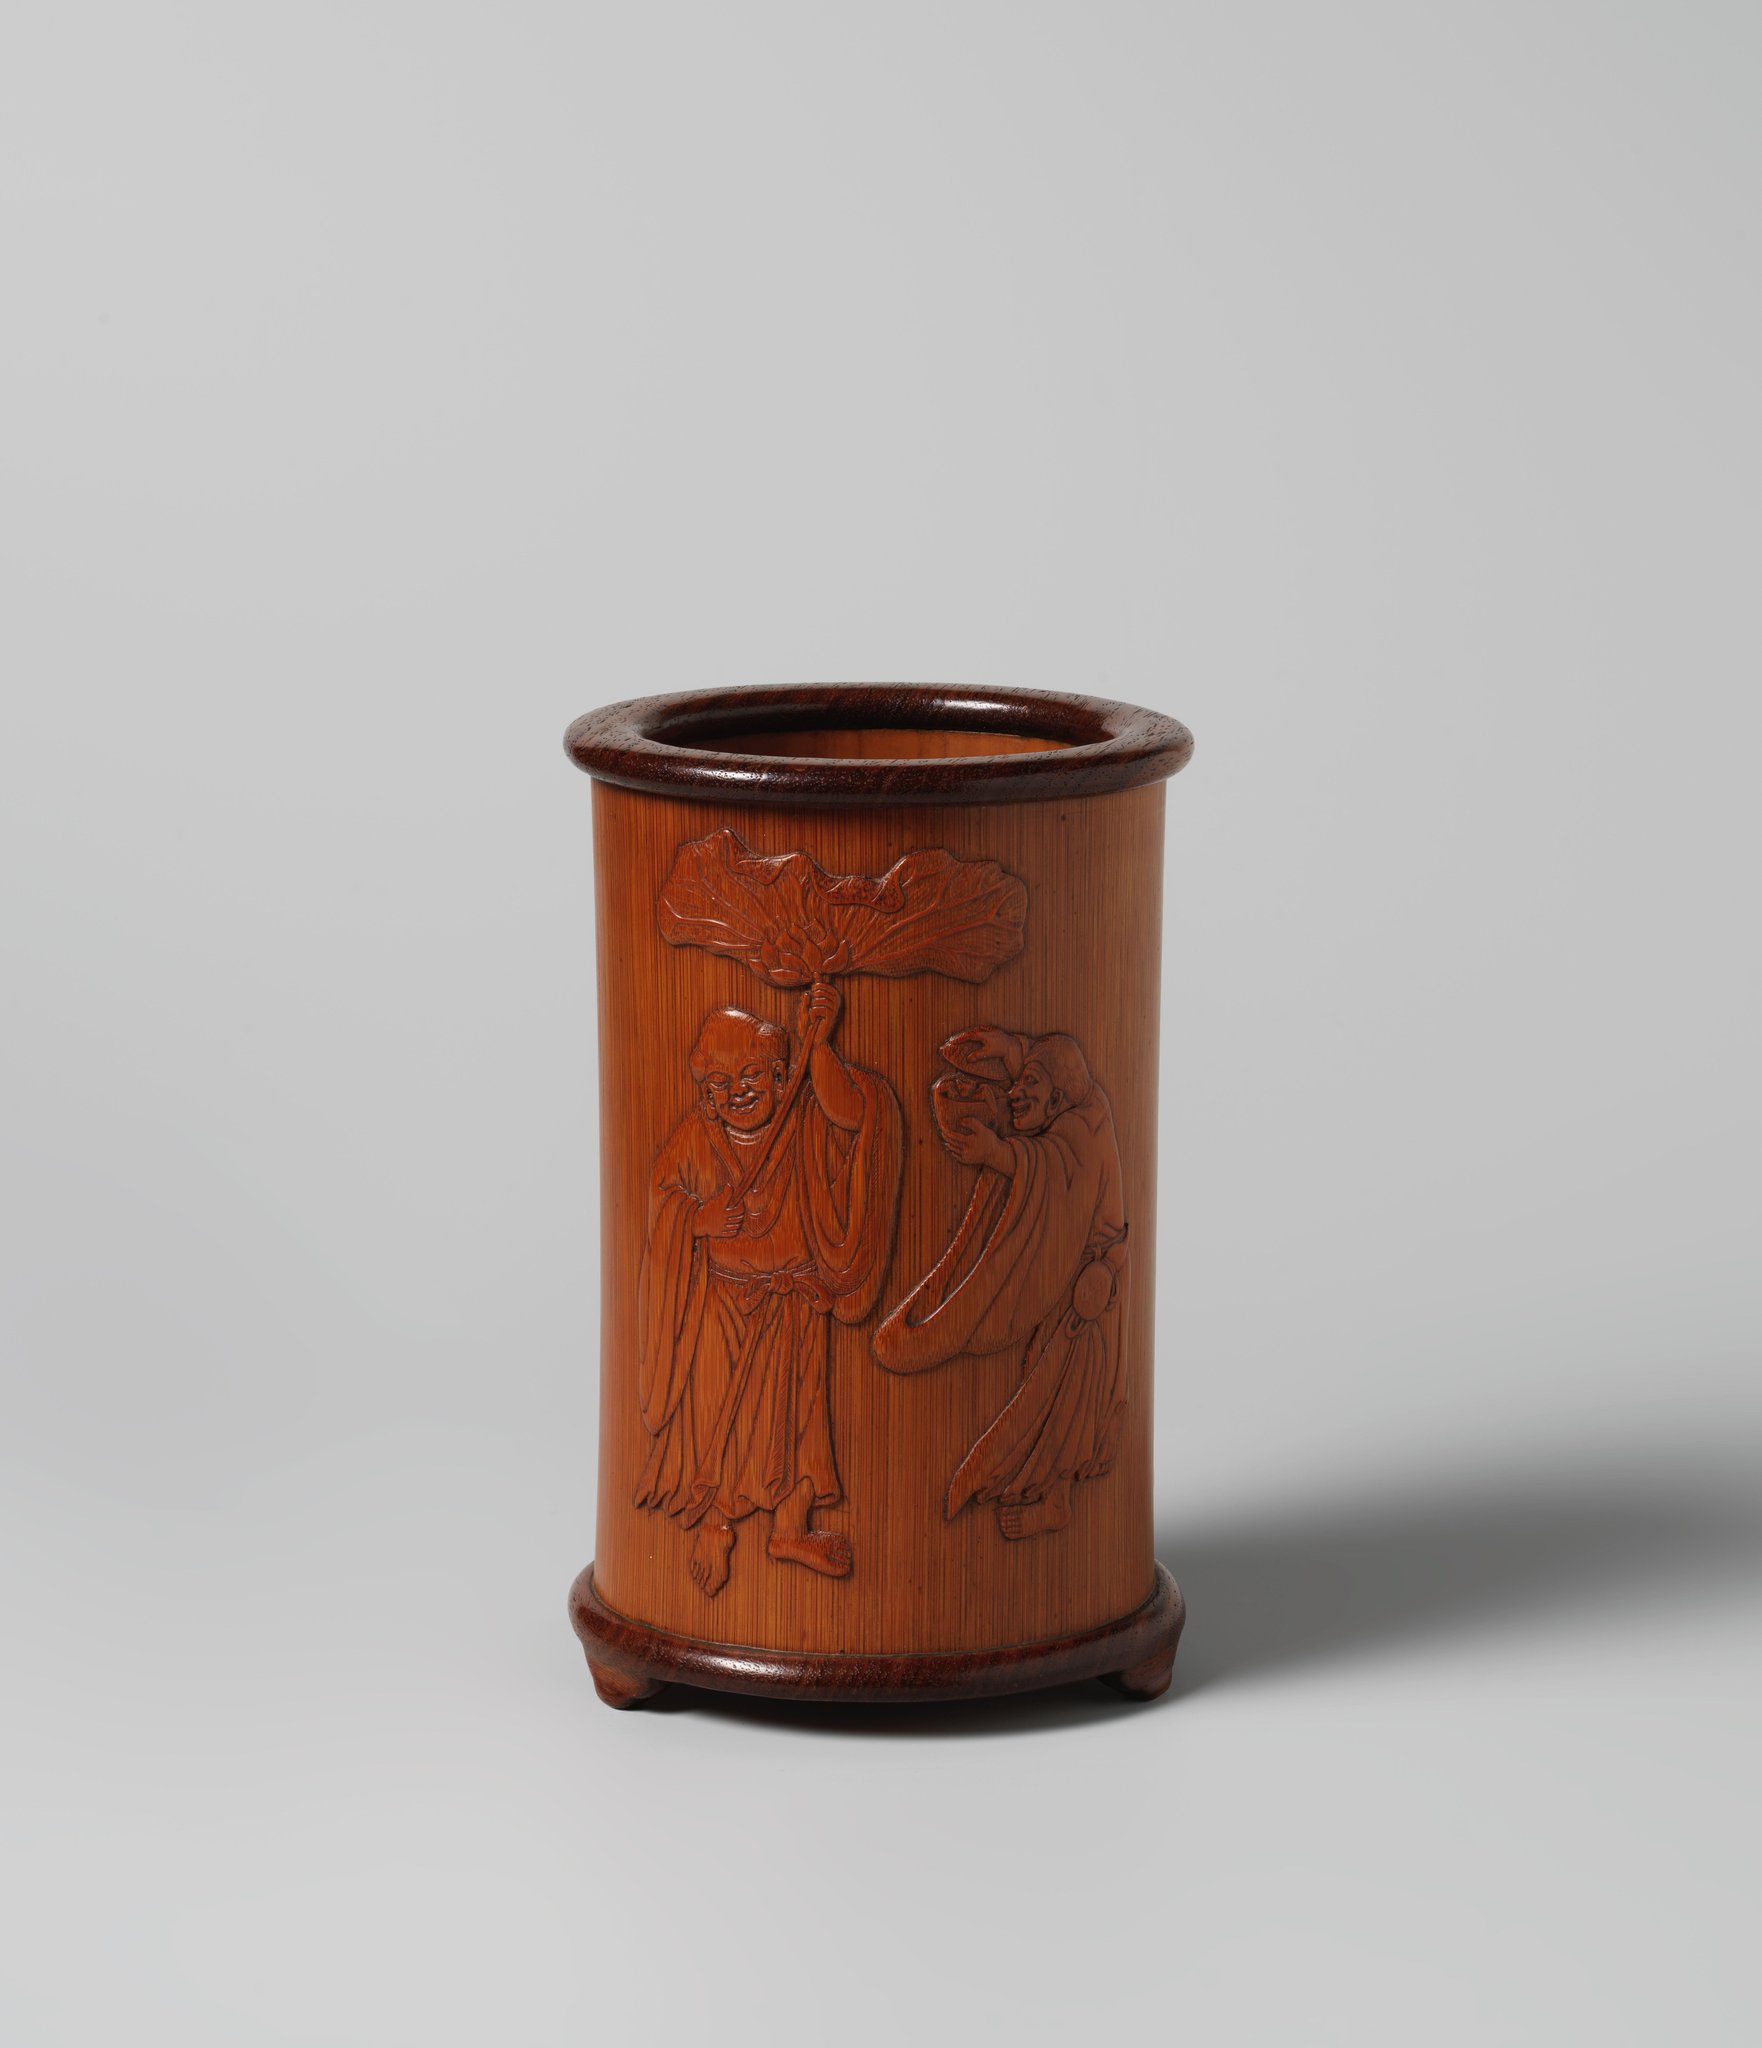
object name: brush holder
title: Brush holder decorated with Hanshan and Shide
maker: danian ma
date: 1644-1911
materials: bamboo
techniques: cutting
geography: china